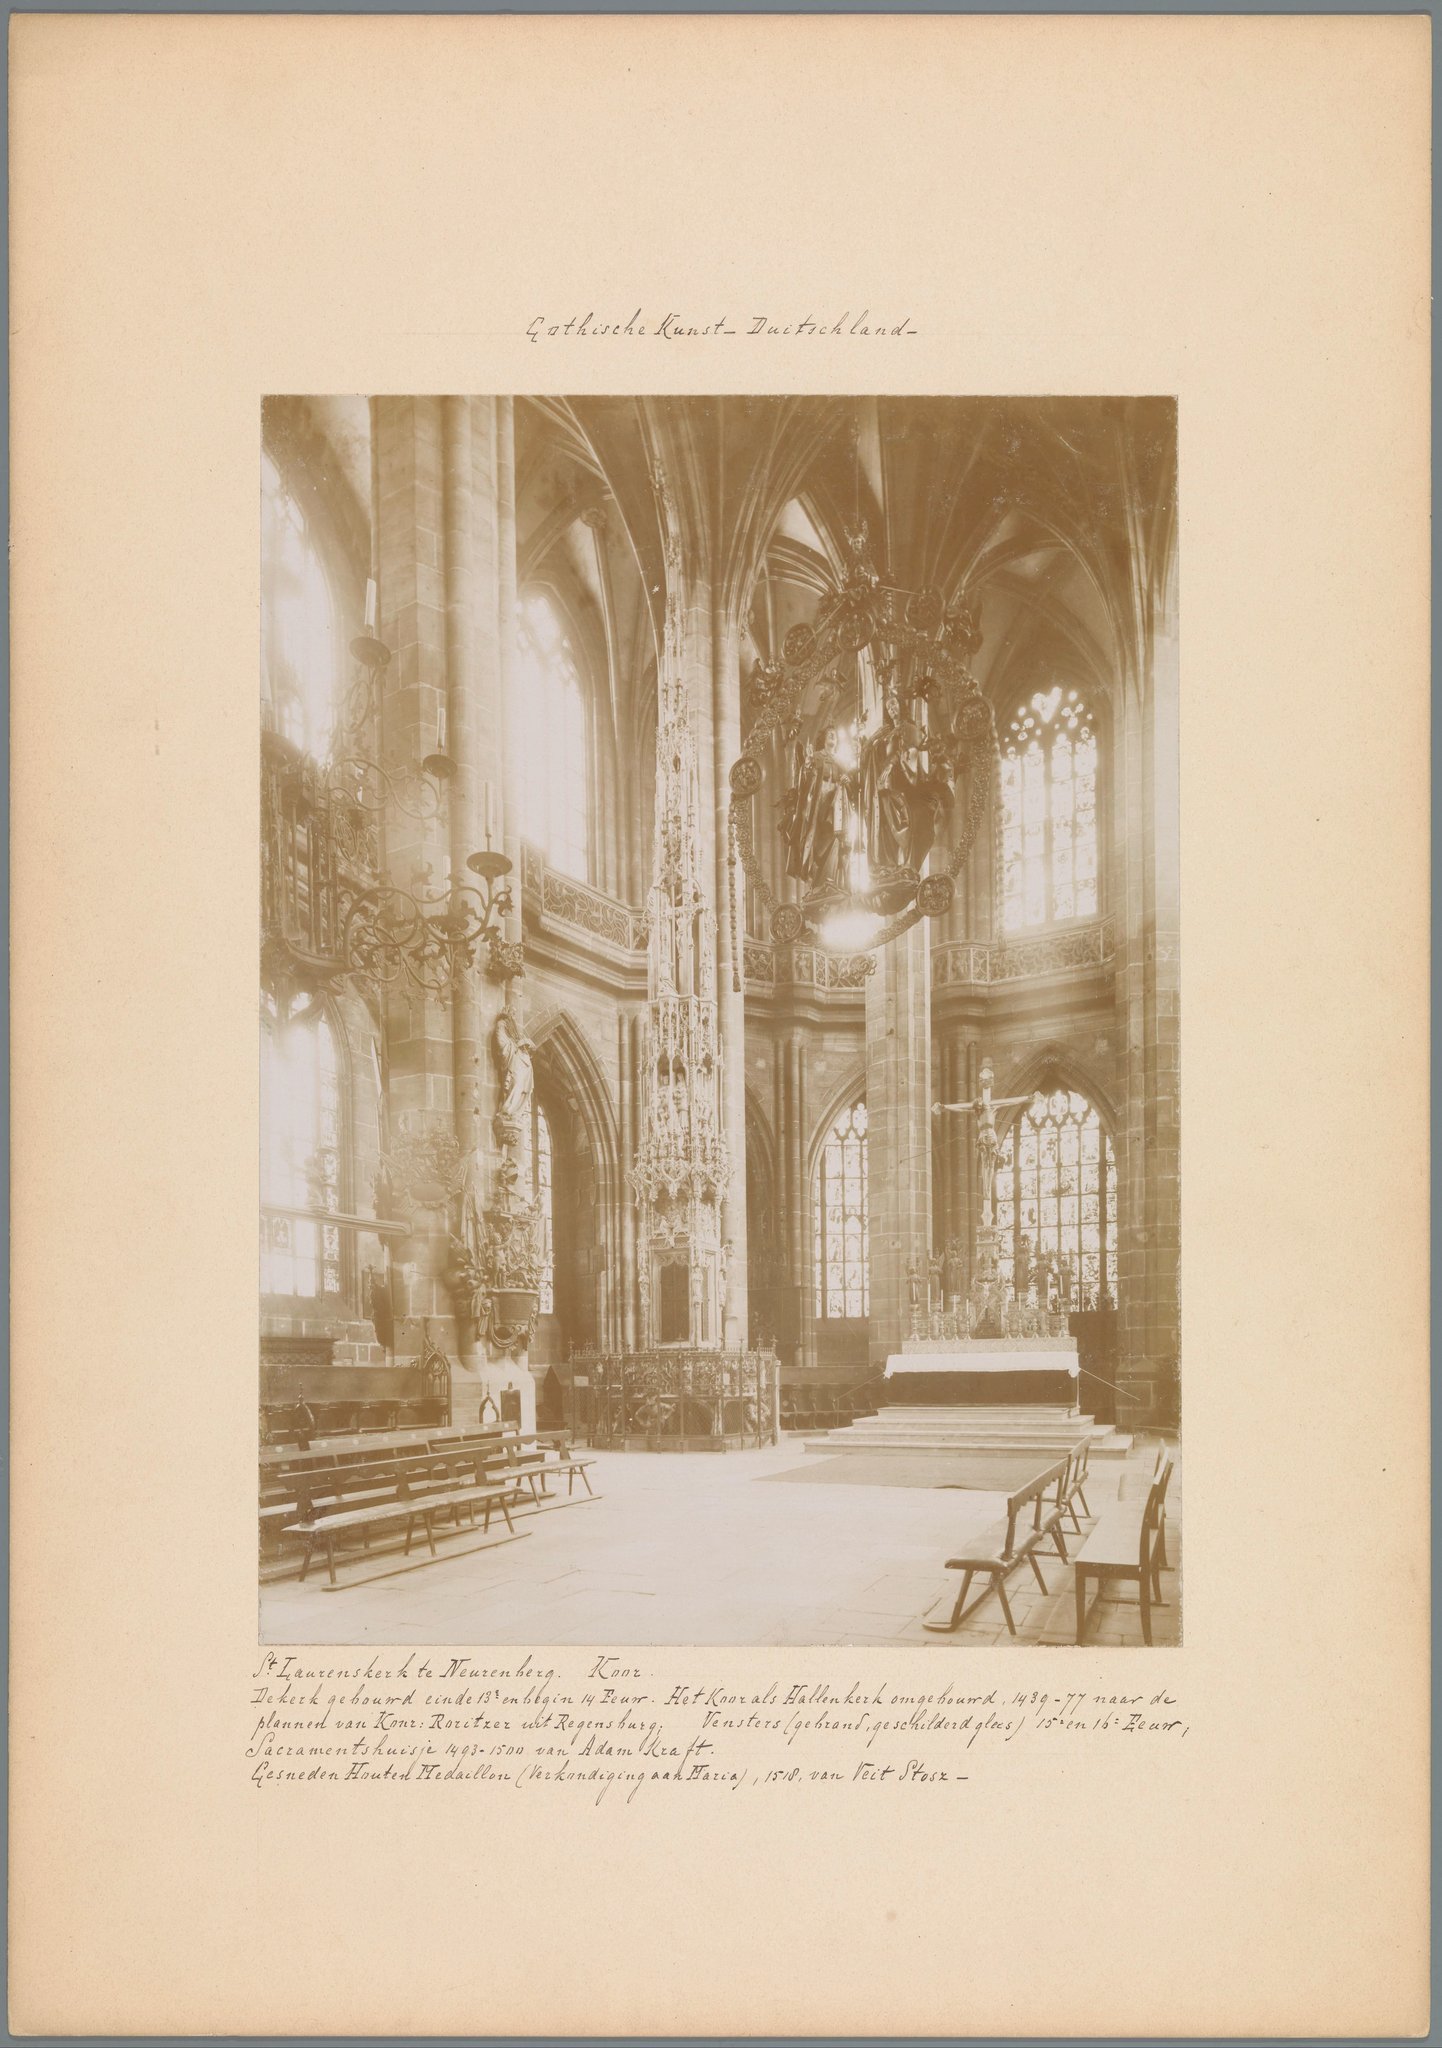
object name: photograph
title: Interieur van de Sint-Laurentiuskerk te Neurenberg gezien naar het koor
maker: Anonymous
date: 1875-1900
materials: cardboard, photographic support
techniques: collodion silver print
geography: nuremberg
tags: parts of church interior: choir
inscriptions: collector's mark: ‘KUNSTNIJVERHEIDSCHOOL QUELLINUS AMSTERDAM FRANS HALSSTRAAT 14.’, collector's mark: ‘INSTITUUT VOOR KUNST-NIJVERHEIDSONDERWIJS GABRIËL METSUSTRAAT No. 16 AMSTERDAM’, inscription: ‘Gothische Kunst - Duitschland.’